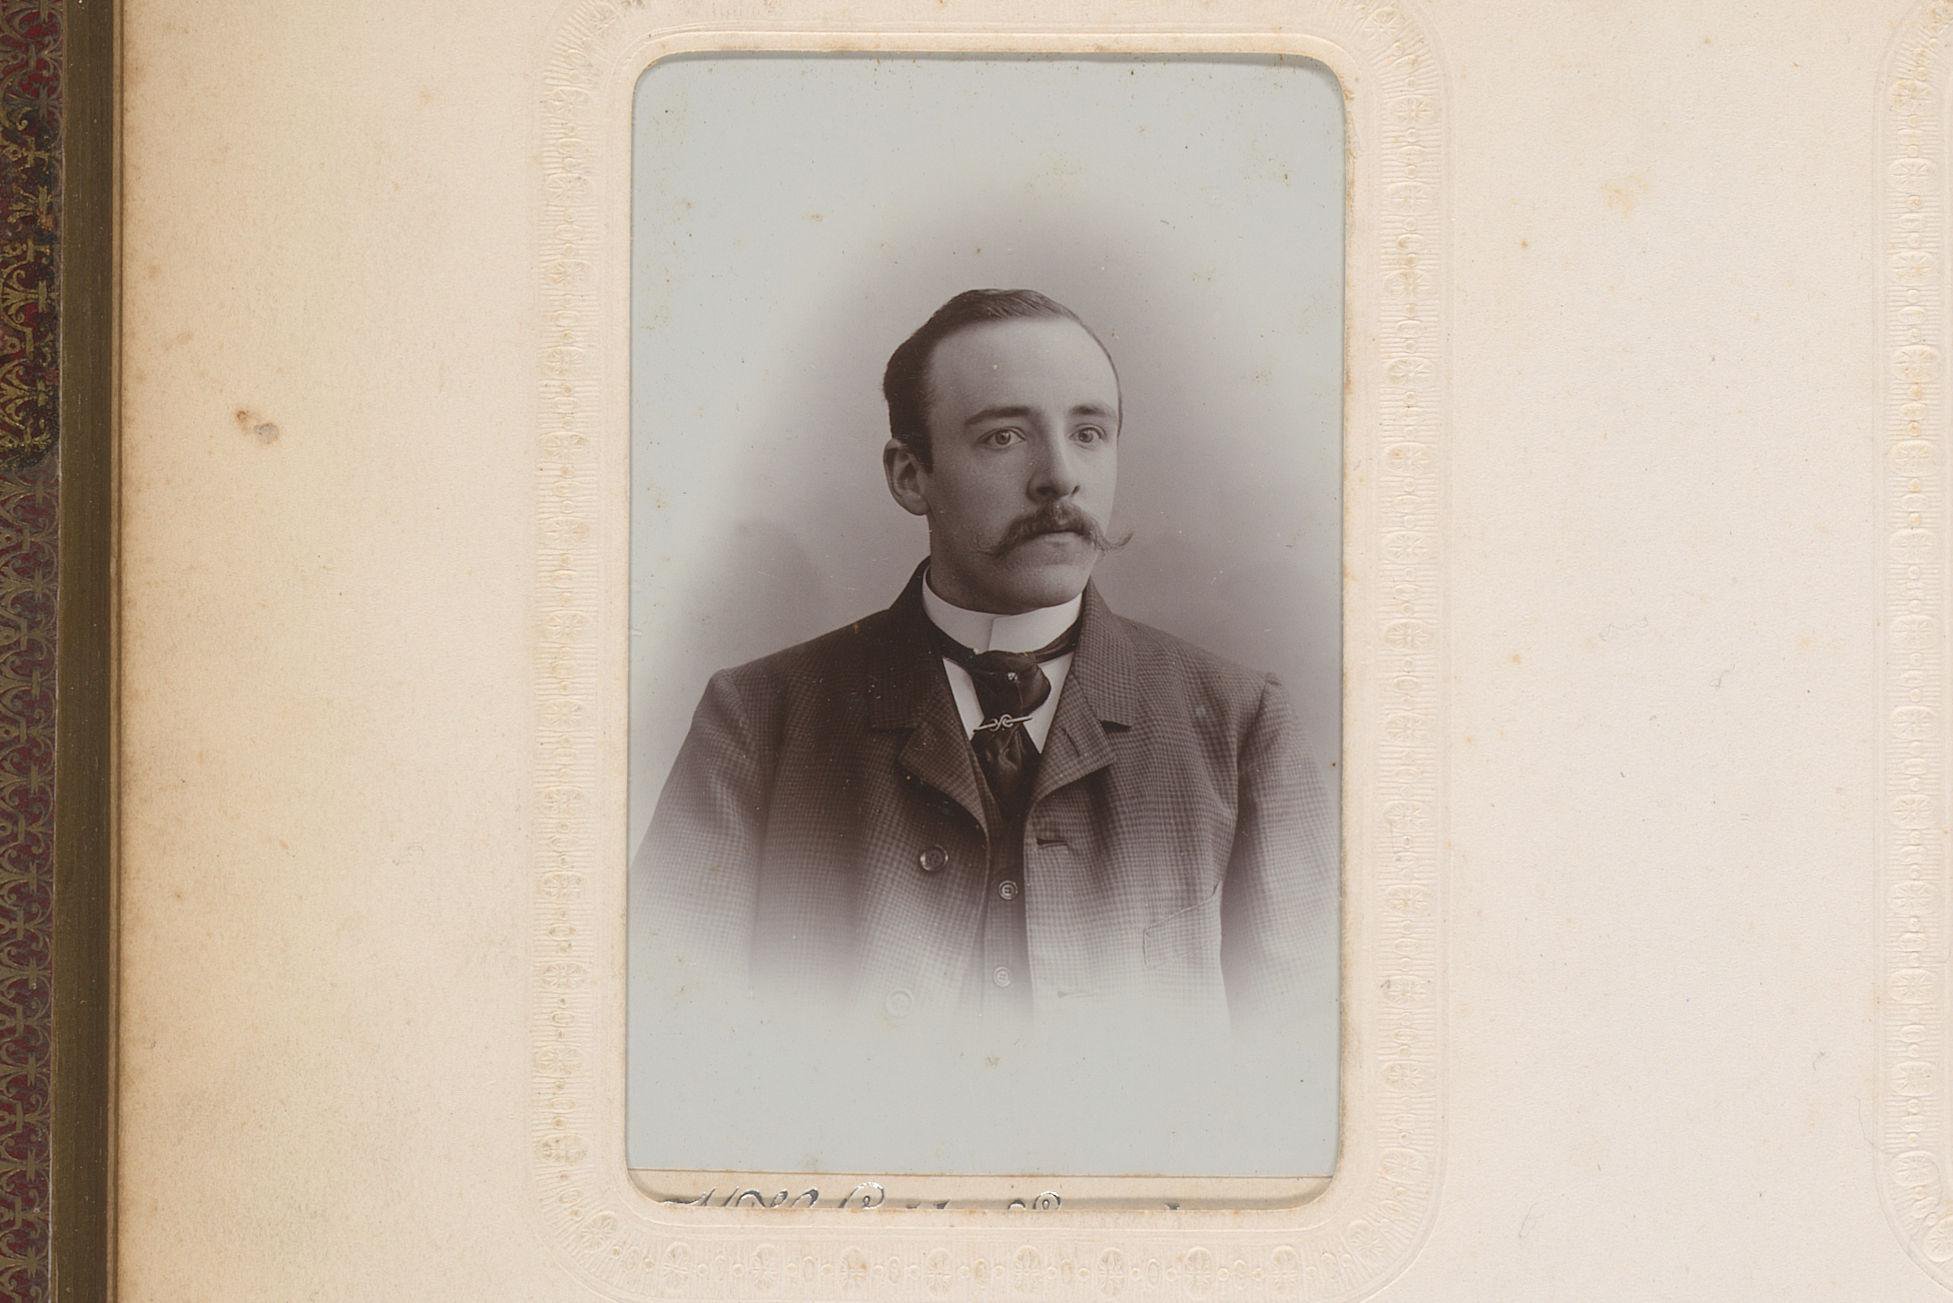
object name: album leaf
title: Portret van een man met snor en stropdas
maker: machiel hendricus laddé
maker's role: fotograaf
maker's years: 1866-1932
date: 1892-1906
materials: cardboard, photographic support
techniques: collodion silver print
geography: amsterdam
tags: moustache, historical persons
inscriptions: inscription: ‘M. H. Laddé/ Amsterdam’